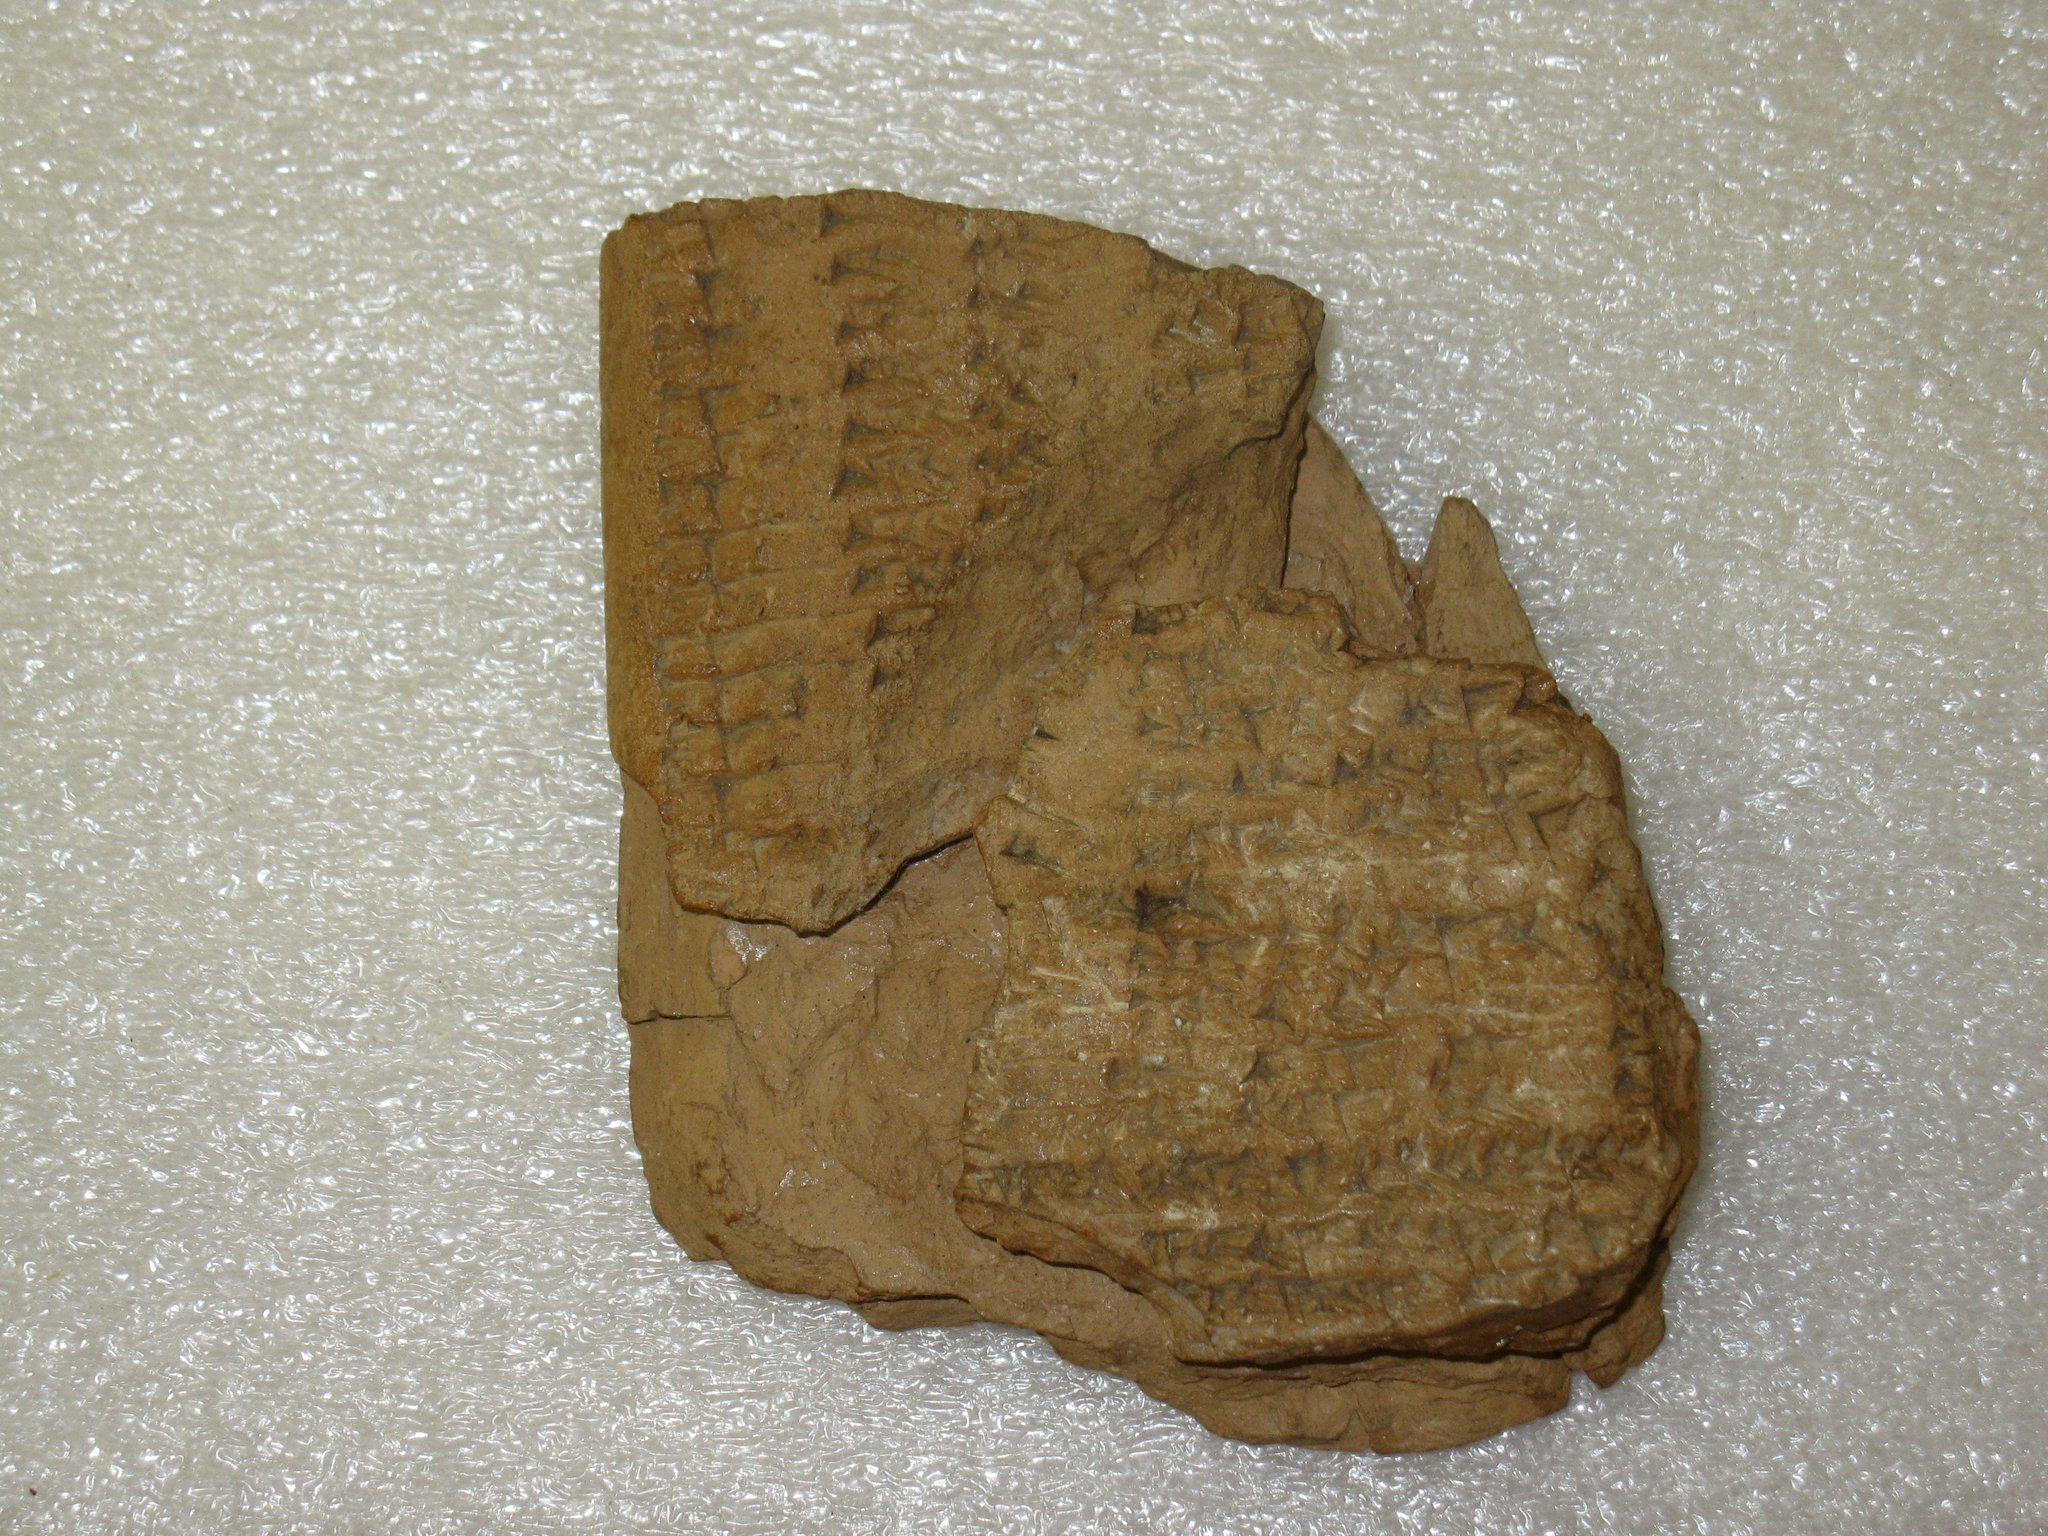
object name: cuneiform tablet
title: Cuneiform tablet: a-she-er gi-ta, balag to Innin/Ishtar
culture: parthian or seleucid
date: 200-1 BCE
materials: clay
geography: mesopotamia